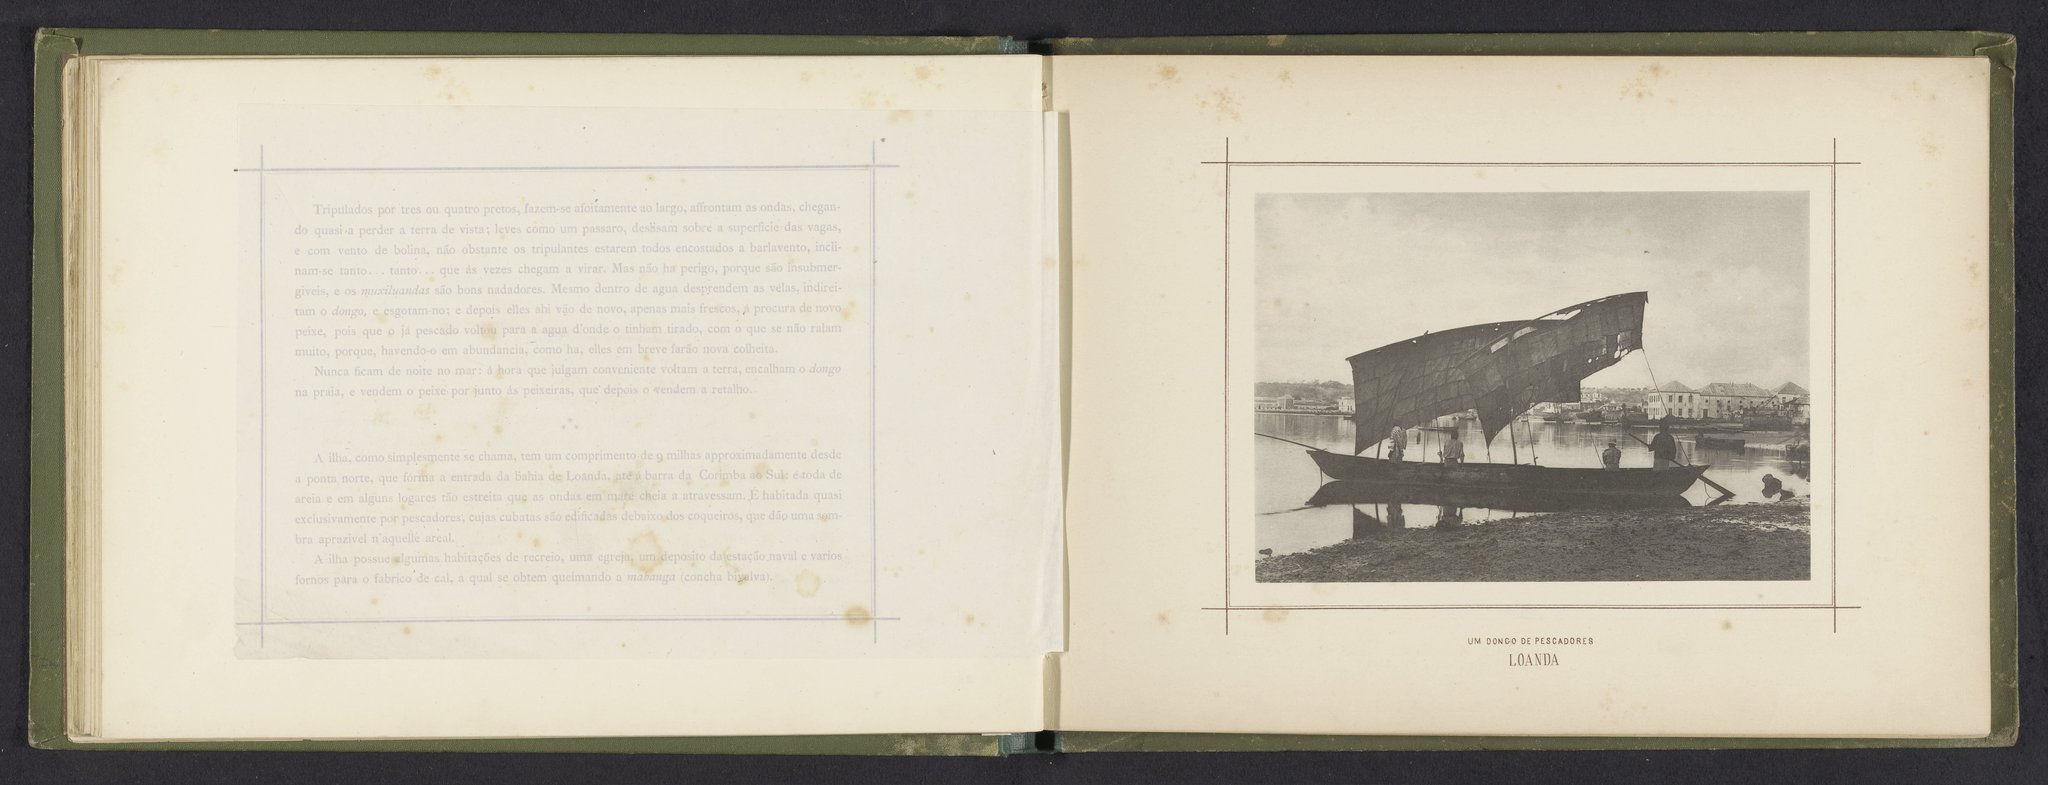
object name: page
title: Loanda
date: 1876-1886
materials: paper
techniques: photograph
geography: luanda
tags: commercial fishery, ships (in general)